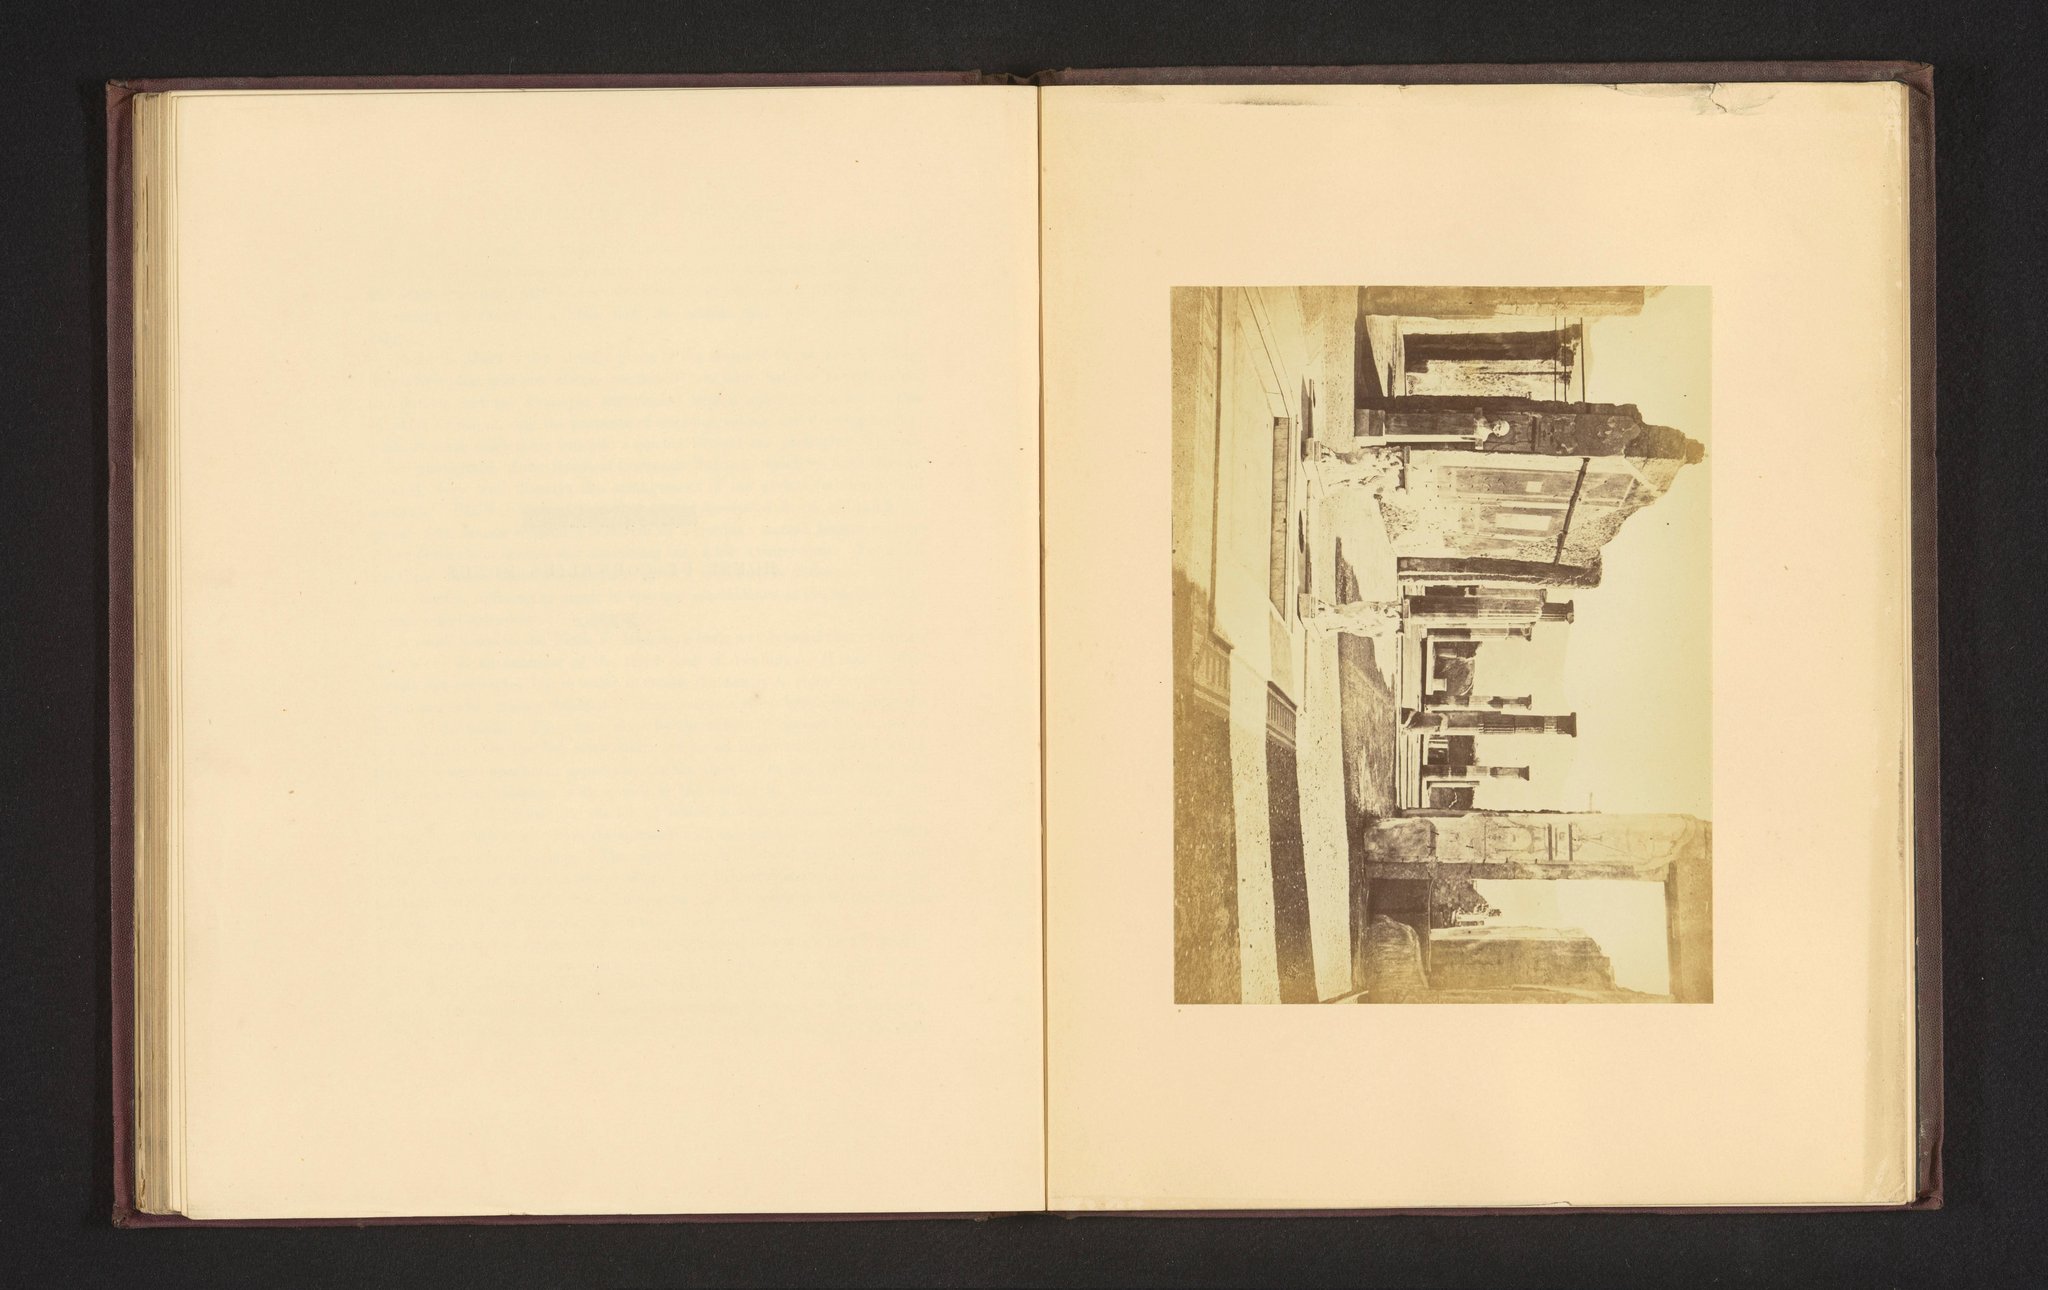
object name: page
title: Gezicht op de ruïnes van Casa di Cornelio Rufo te Pompeï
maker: Anonymous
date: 1862-1867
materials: cardboard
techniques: albumen print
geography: pompeii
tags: ruin of a building ~ architecture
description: Foto op derde ongenummerde pagina na pagina 74.